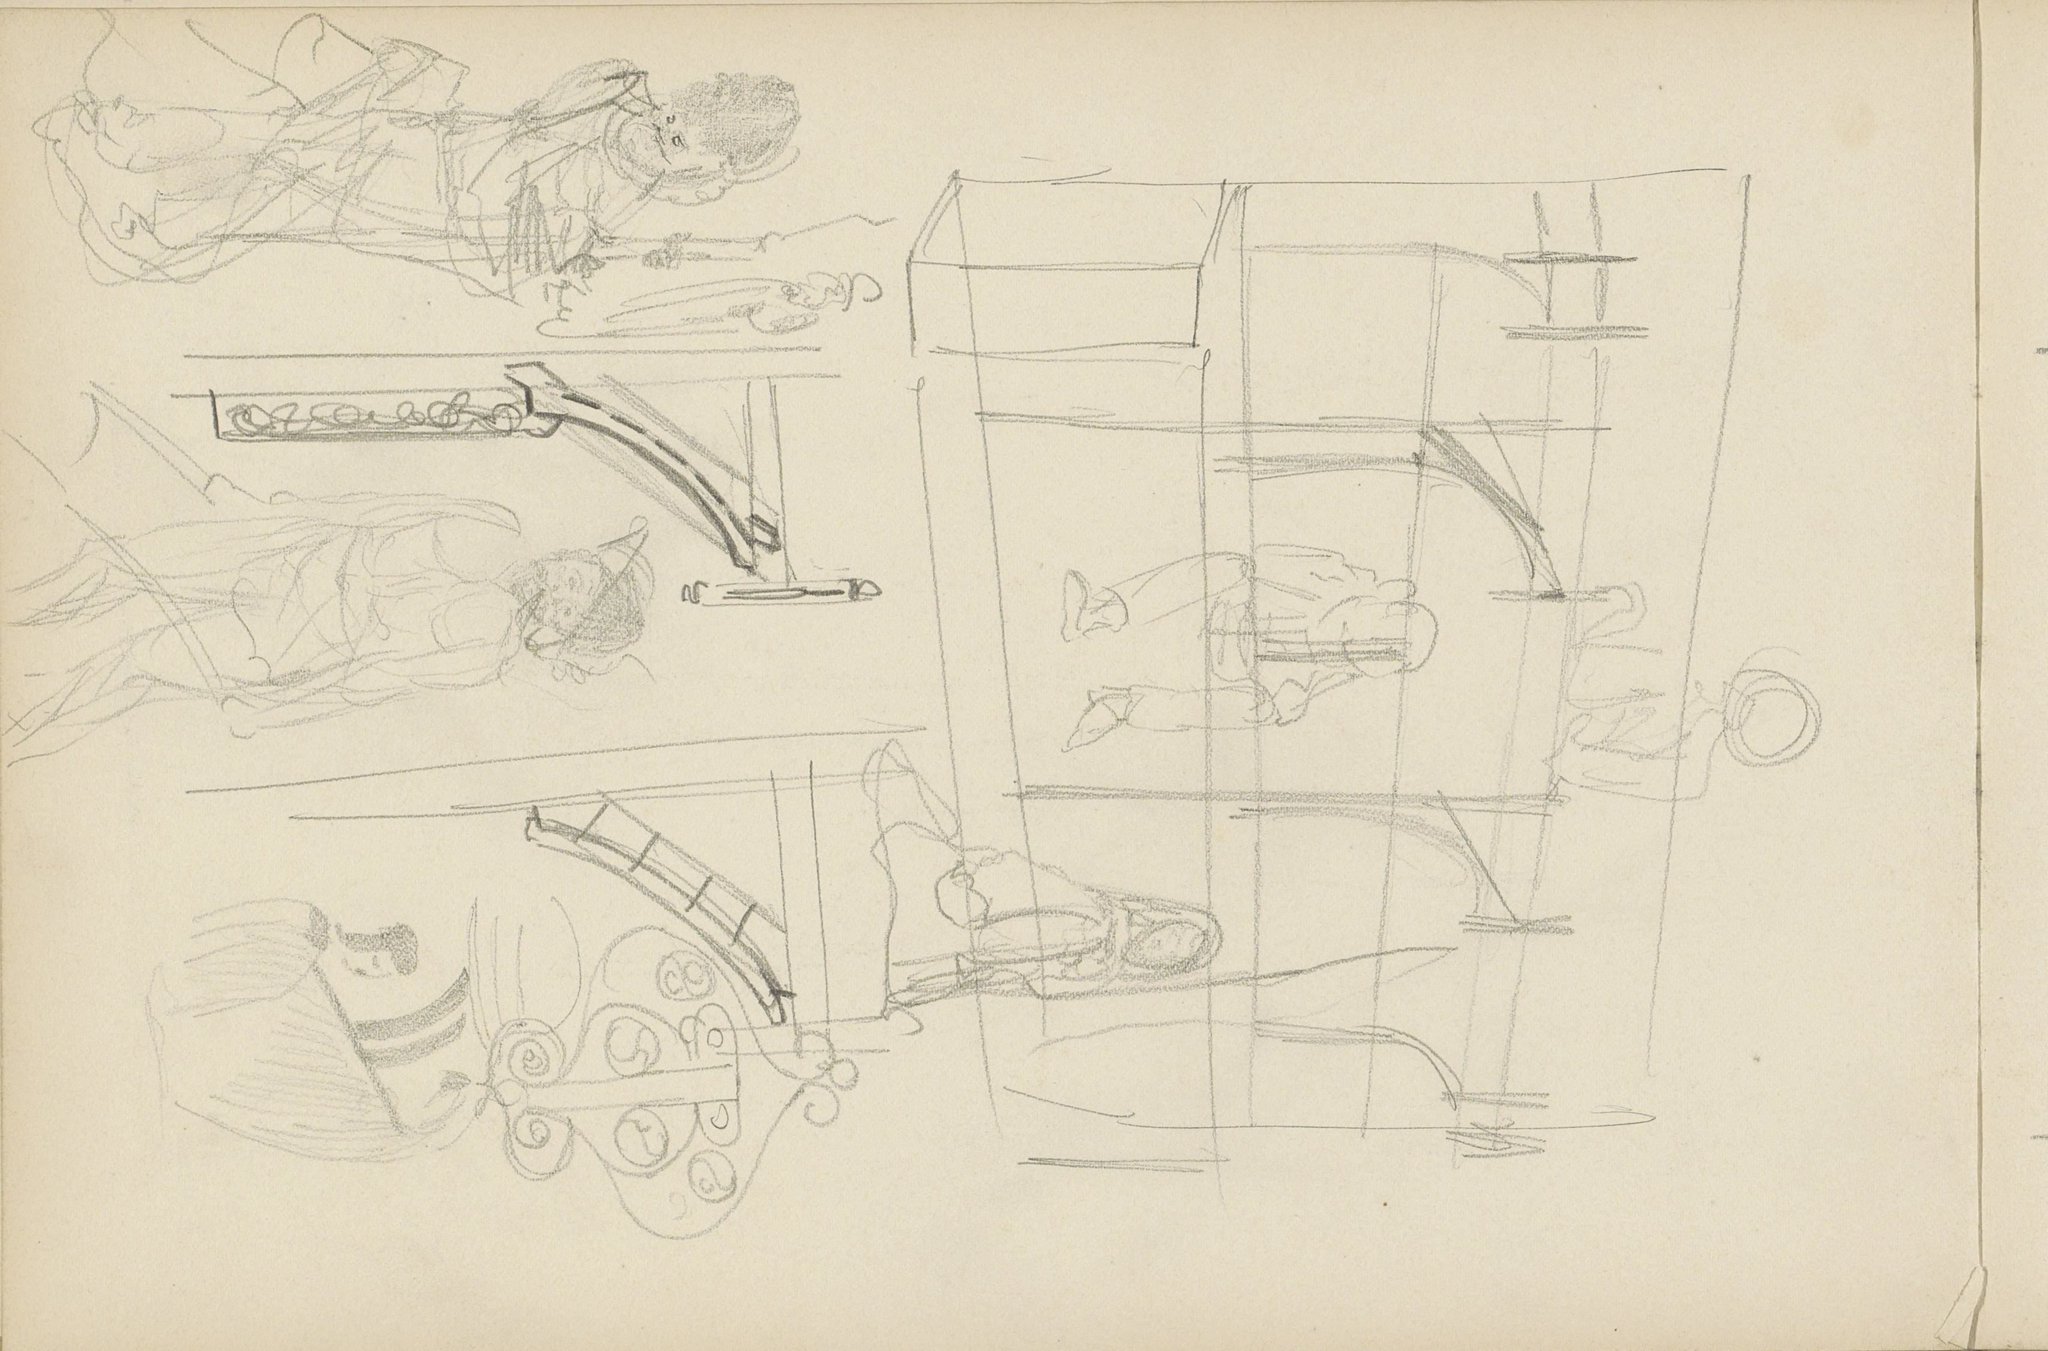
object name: sketchbook leaf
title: Architectuurstudies, figuren en ornamenten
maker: carel adolph lion cachet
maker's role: draughtsman, print maker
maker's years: 1864-1945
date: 1908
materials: paper, pencil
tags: standing figure, ornaments ~ art, architecture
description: Blad 8 verso uit een schetsboek met 25 bladen.